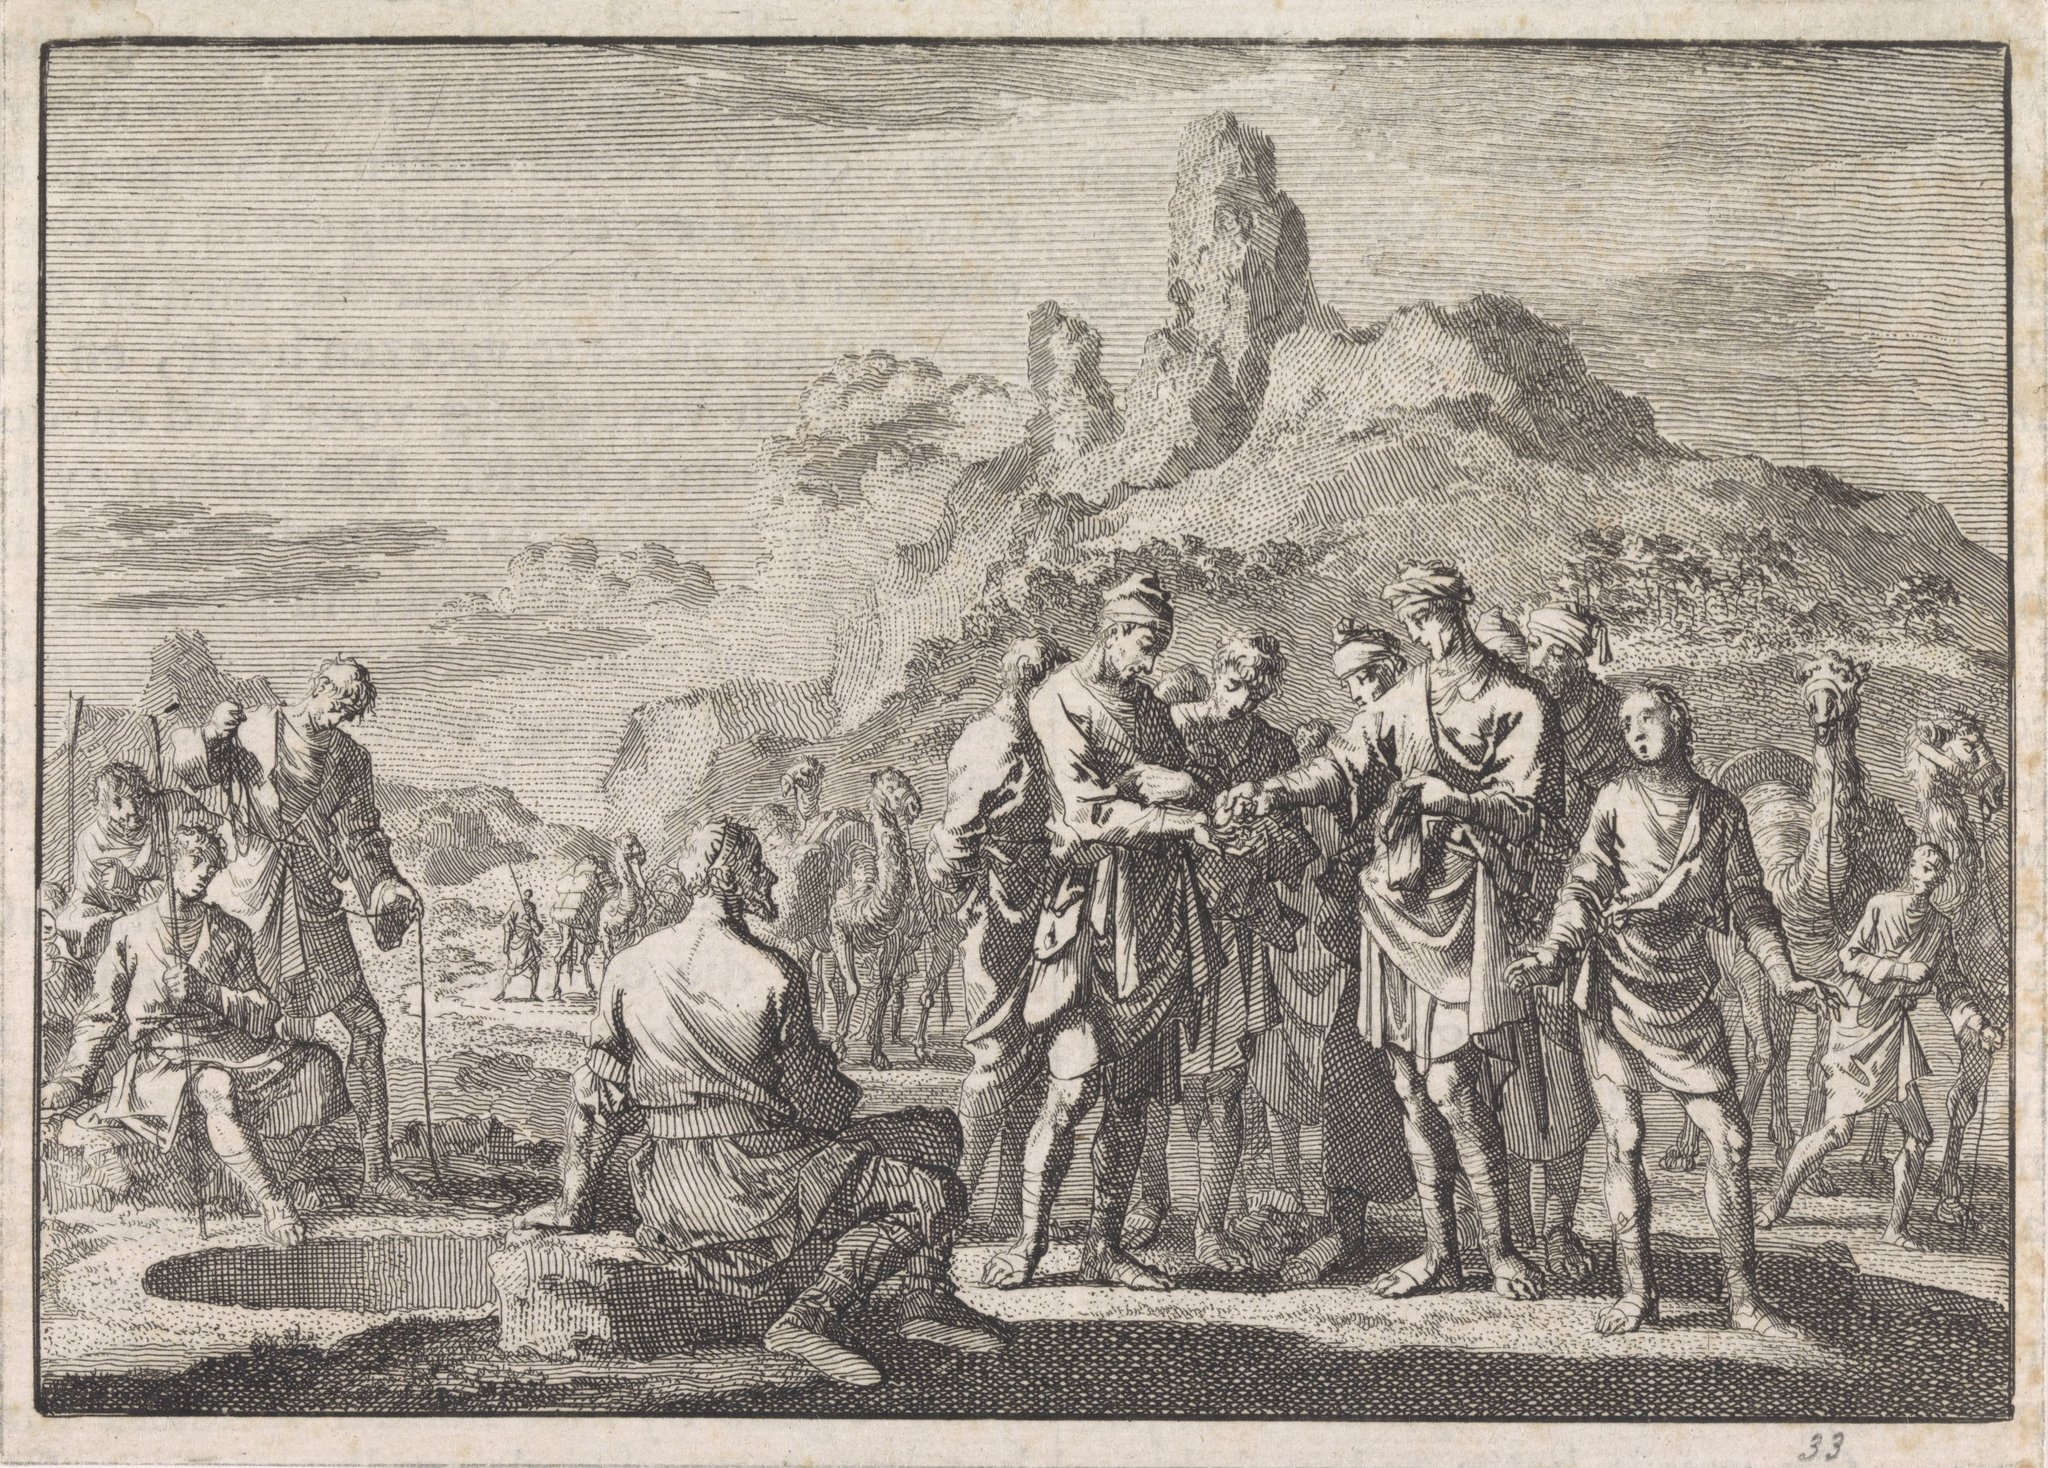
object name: book illustration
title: Jozef door zijn broers aan handelaren verkocht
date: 1704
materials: paper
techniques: etching, letterpress printing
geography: amsterdam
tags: while joseph's brothers are eating, a caravan of ishmaelite (midianite) merchants passes by: judah proposes to sell joseph to them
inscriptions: collector's mark: Lugt 2228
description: Prent opgenomen in: Josephus, Flavius. Alle de Werken, 2 delen. Amsterdam: Pieter Mortier, 1704, dl. 1, p. 33.